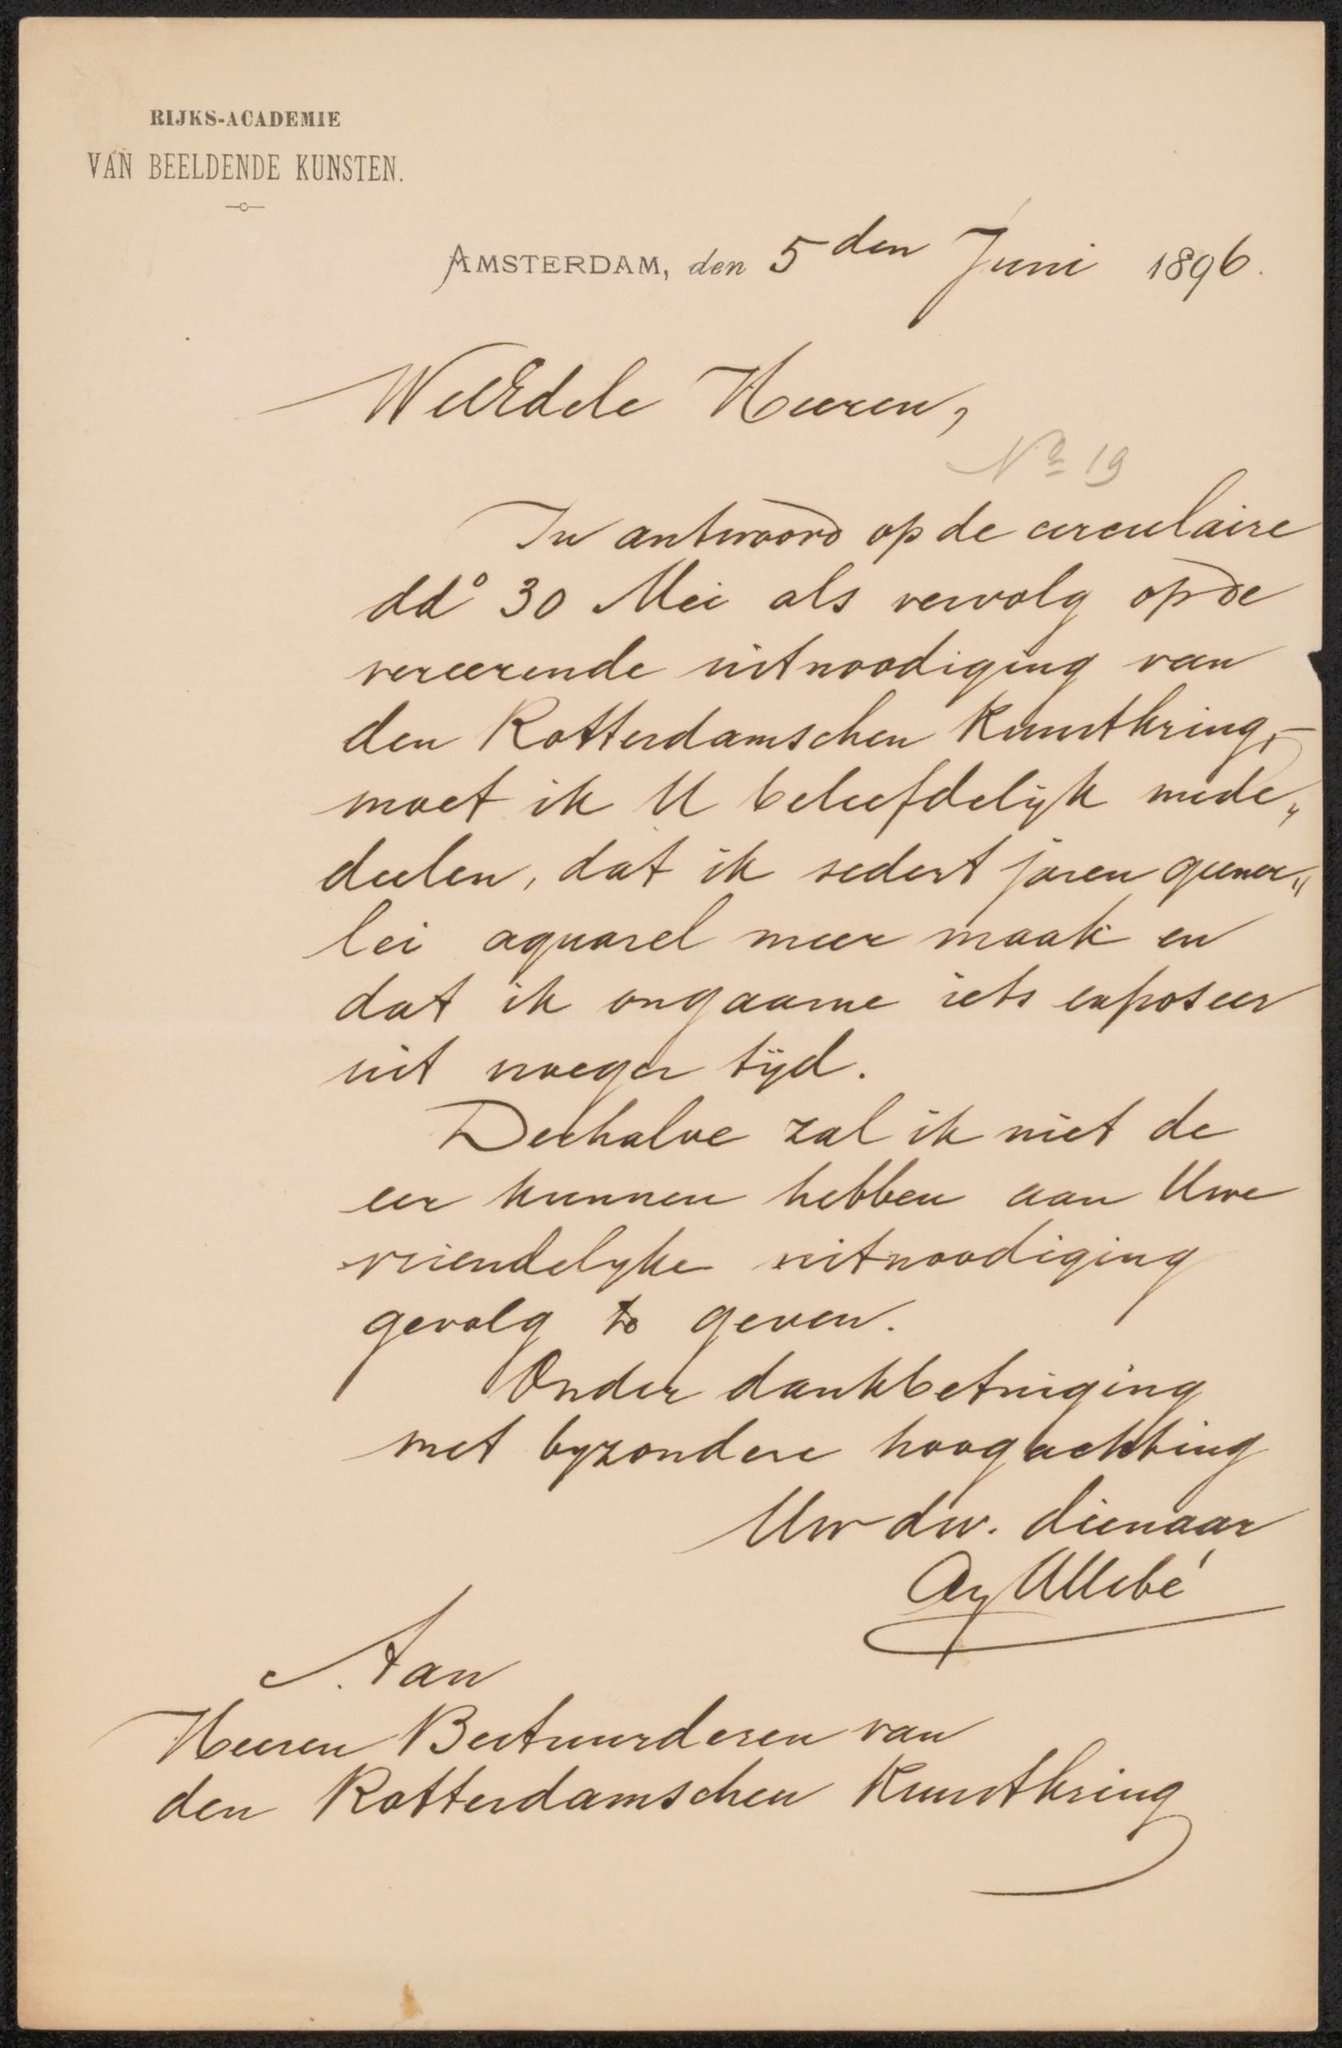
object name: letter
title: Brief aan de Rotterdamsche Kunstkring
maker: august allebé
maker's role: draughtsman, print maker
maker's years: 1838-1927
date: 1896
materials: ink, paper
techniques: pen, printing, writing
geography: amsterdam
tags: drawing, exhibition ~ art